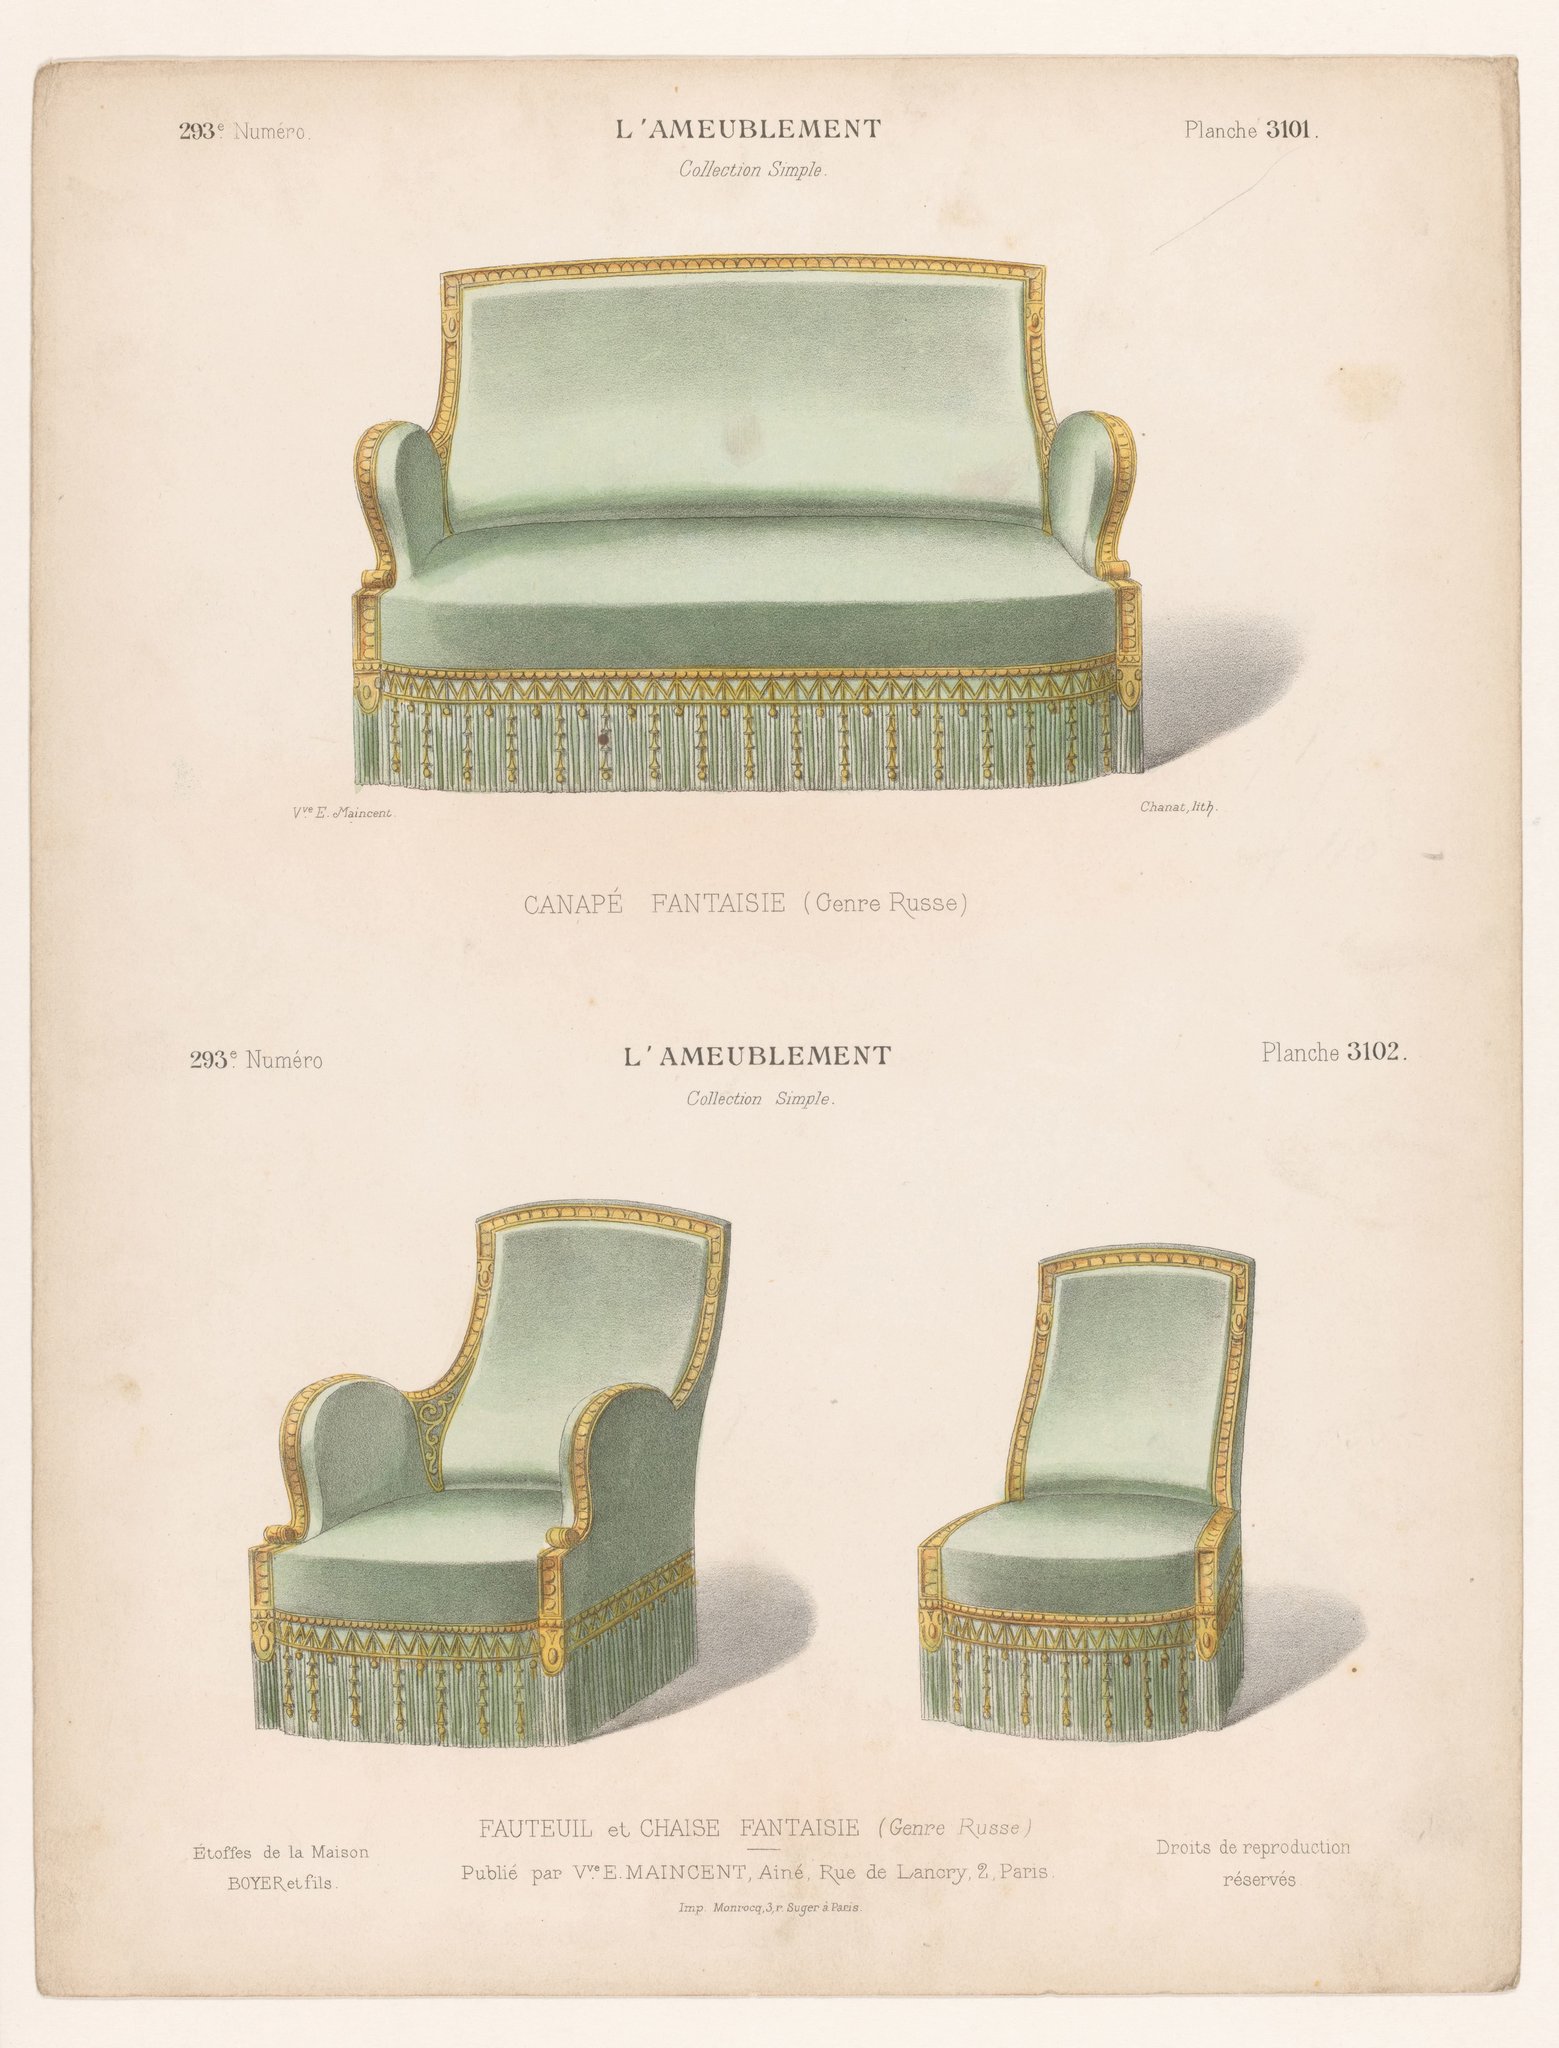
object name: print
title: L'ameublement / Collection simple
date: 1895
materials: paper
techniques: hand coloring, lithograph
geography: paris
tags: seating furniture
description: Een canapé, fauteuil en een stoel. Prent uit 293e nummer (livraison).